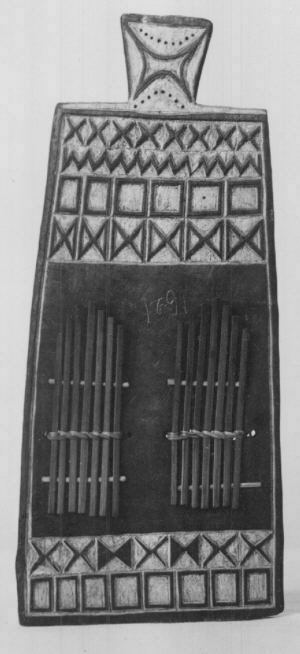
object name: zanze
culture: cameroonian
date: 1867-1900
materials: wood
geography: cameroon